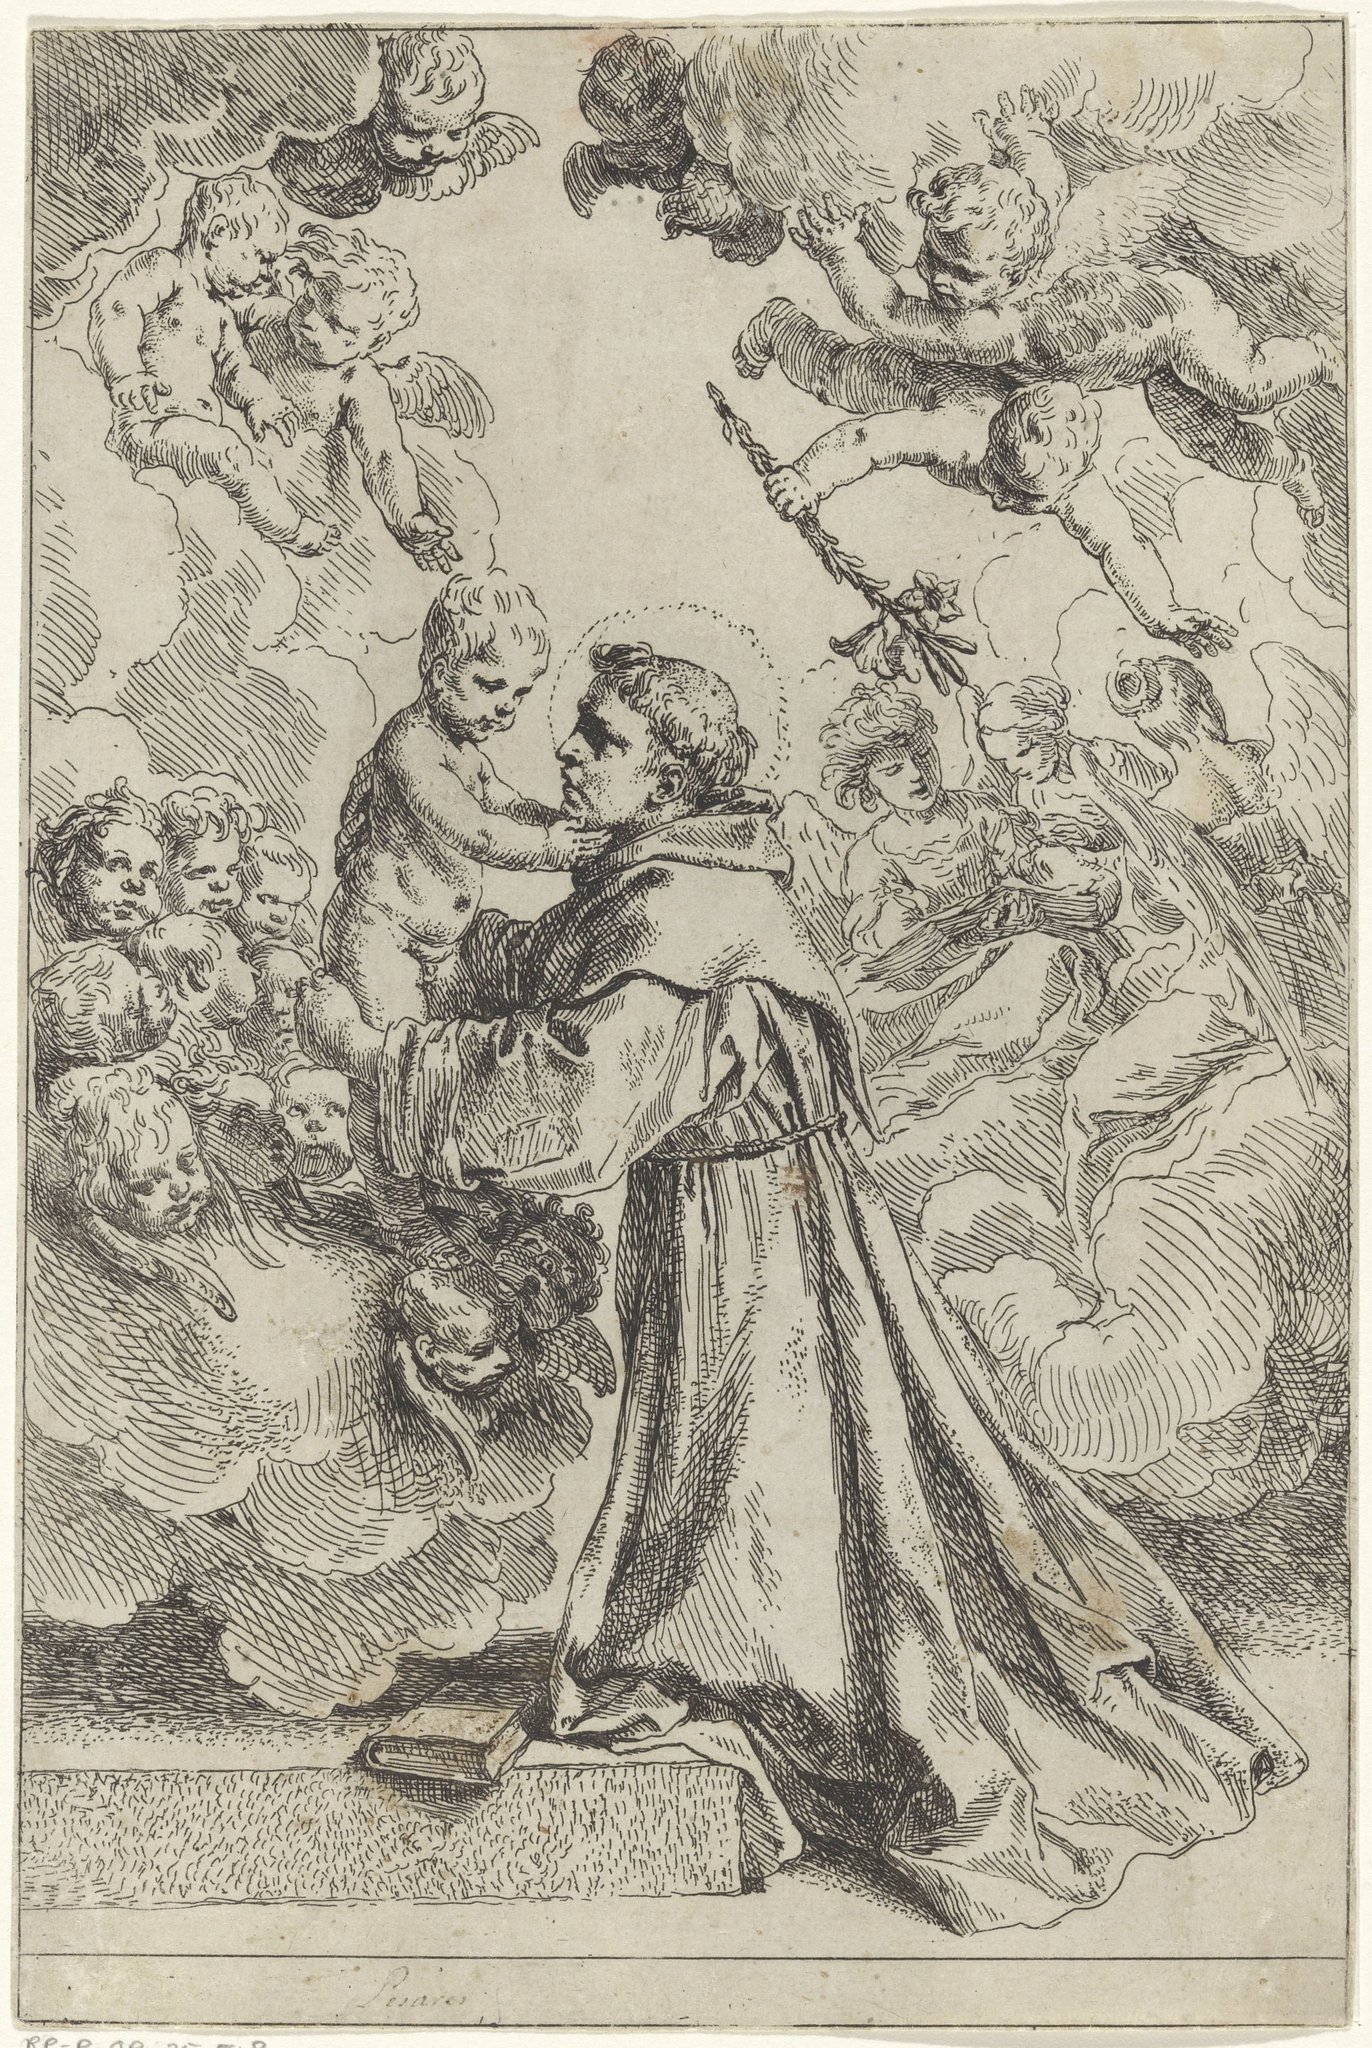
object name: print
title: Heilige Antonius van Padua aanbidt het Christuskind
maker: simone cantarini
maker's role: draughtsman, print maker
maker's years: 1612-1648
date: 1622-1648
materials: paper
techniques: etching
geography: italy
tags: angels, the franciscan monk antony of padua; possible attributes: ass, book, crucifix, flowered cross, flaming heart, infant christ (on book), lily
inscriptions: collector's mark: Lugt 2228, inscription: ‘Pesares’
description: De Heilige Antonius van Padua zit geknield voor het Christuskind. Ze worden omringd door cherubijnen en putti.